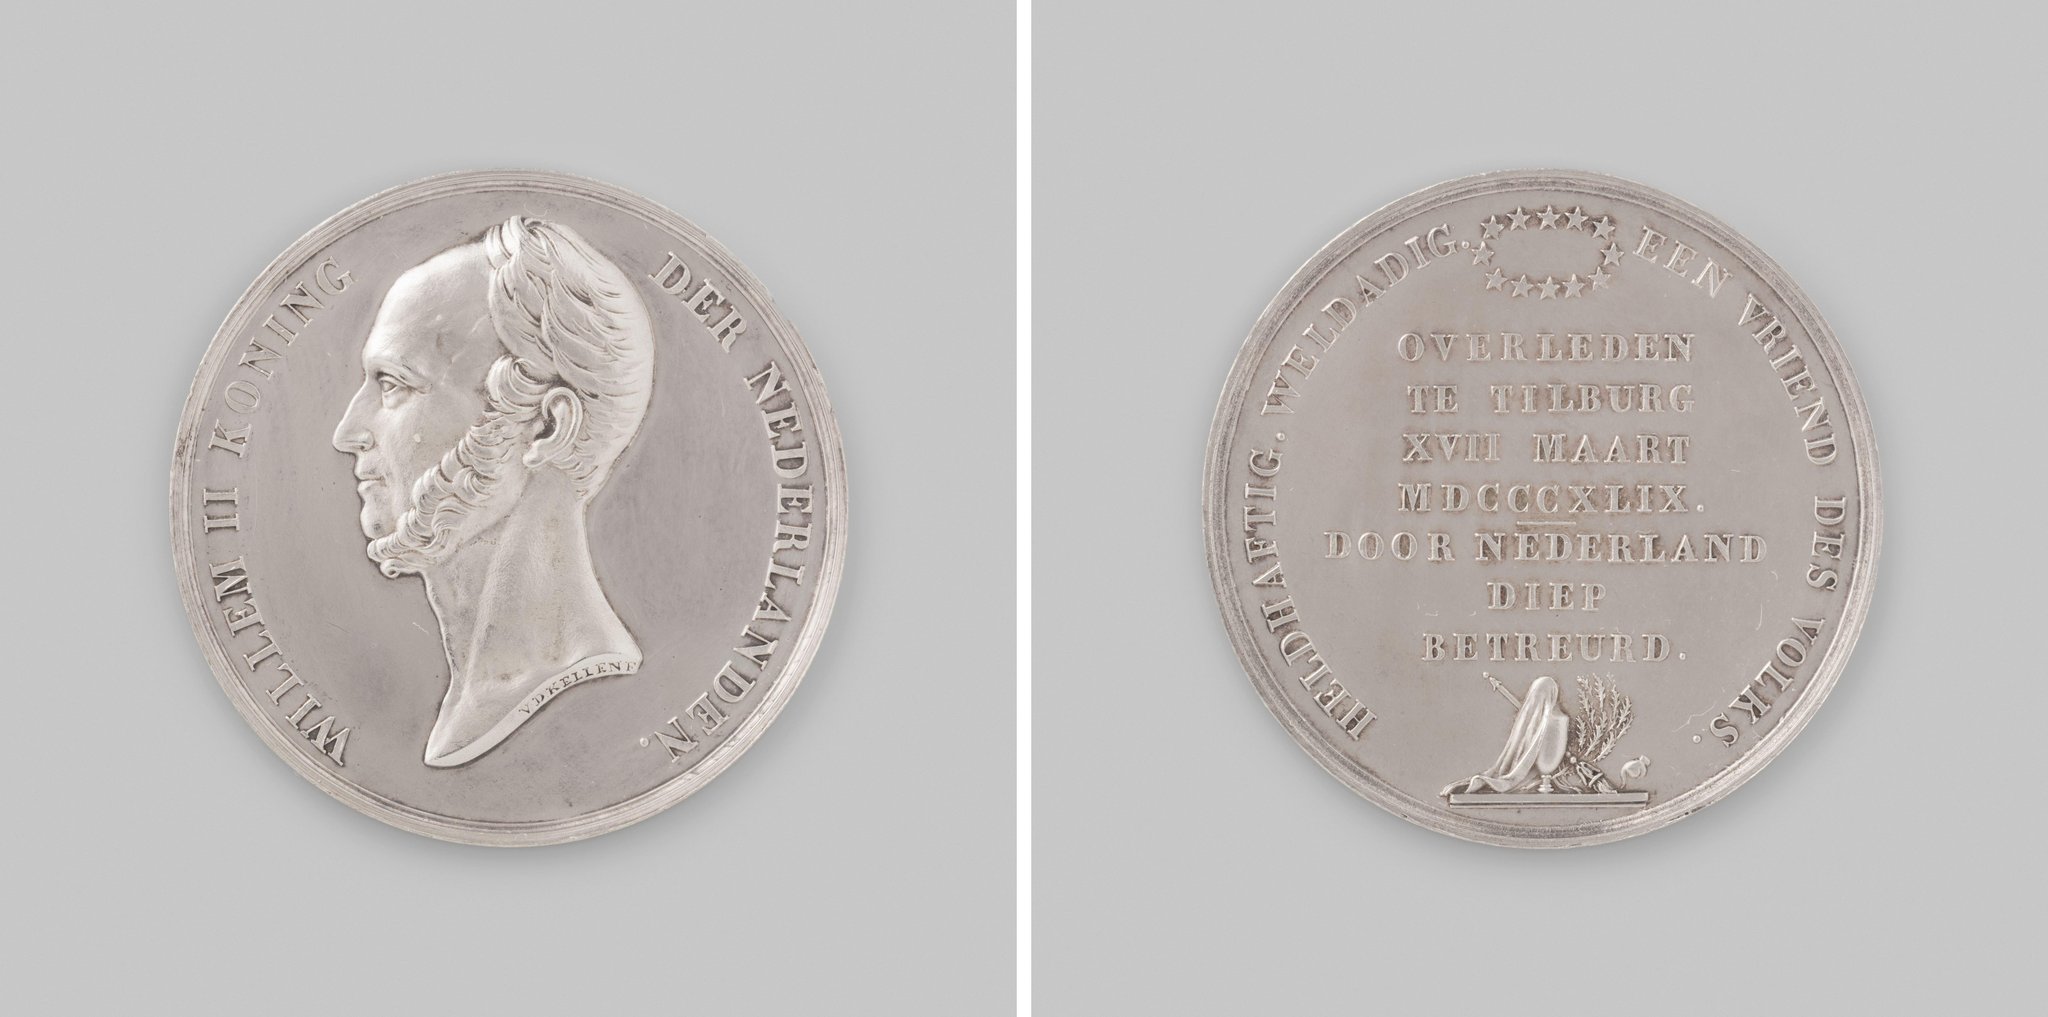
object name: history medal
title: Overlijden van Willem II, koning der Nederlanden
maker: david van der kellen (1804-1879)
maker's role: die cutter, draughtsman, print maker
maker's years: 1804-1879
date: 1849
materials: silver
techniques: striking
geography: utrecht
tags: the hague, william ii of the netherlands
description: Zilveren penning. Voorzijde: borststuk man binnen omschrift. Keerzijde: opschrift onder sterrenkrans bovenvoor helft met doek bedekte lijkurn, rokende fakkel en cypressetak binnen omschrift